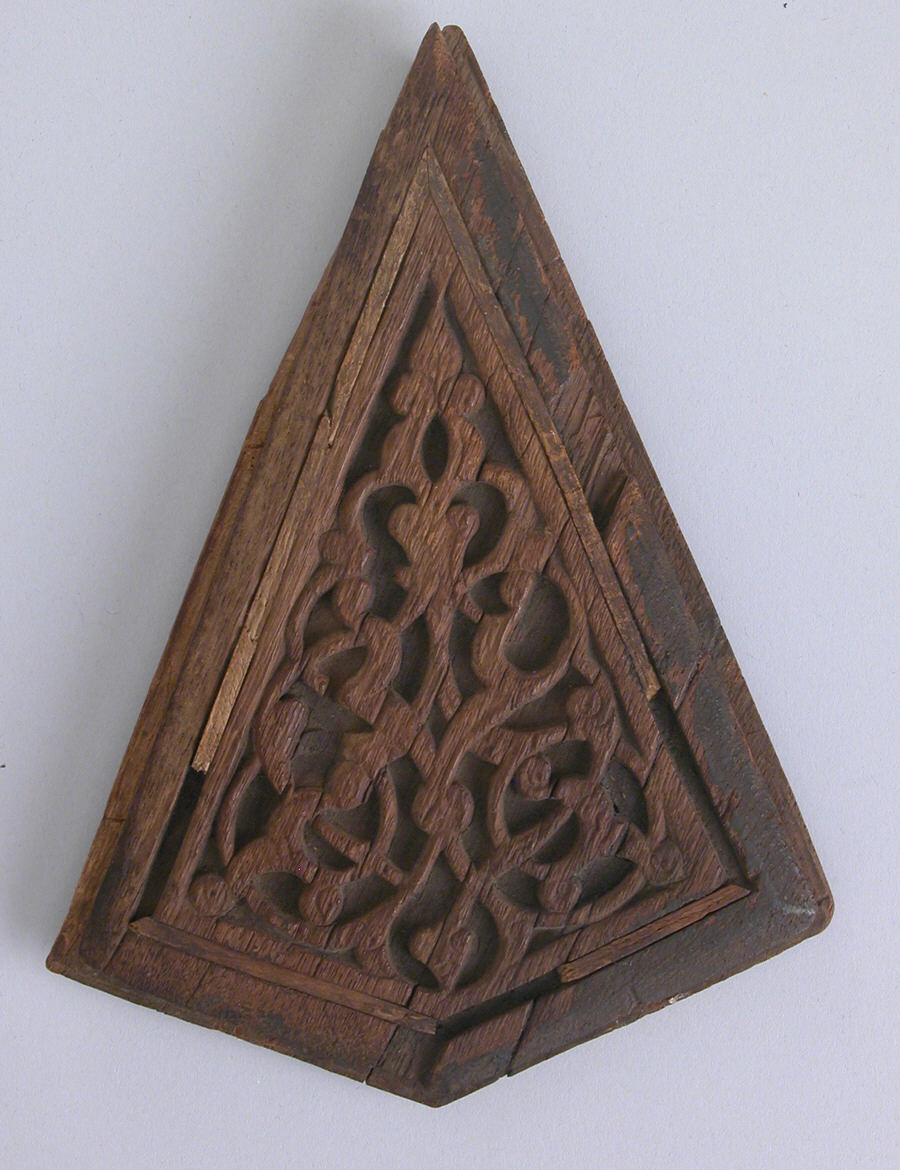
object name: panel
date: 1201-1400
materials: ivory, wood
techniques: carving, inlay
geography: egypt